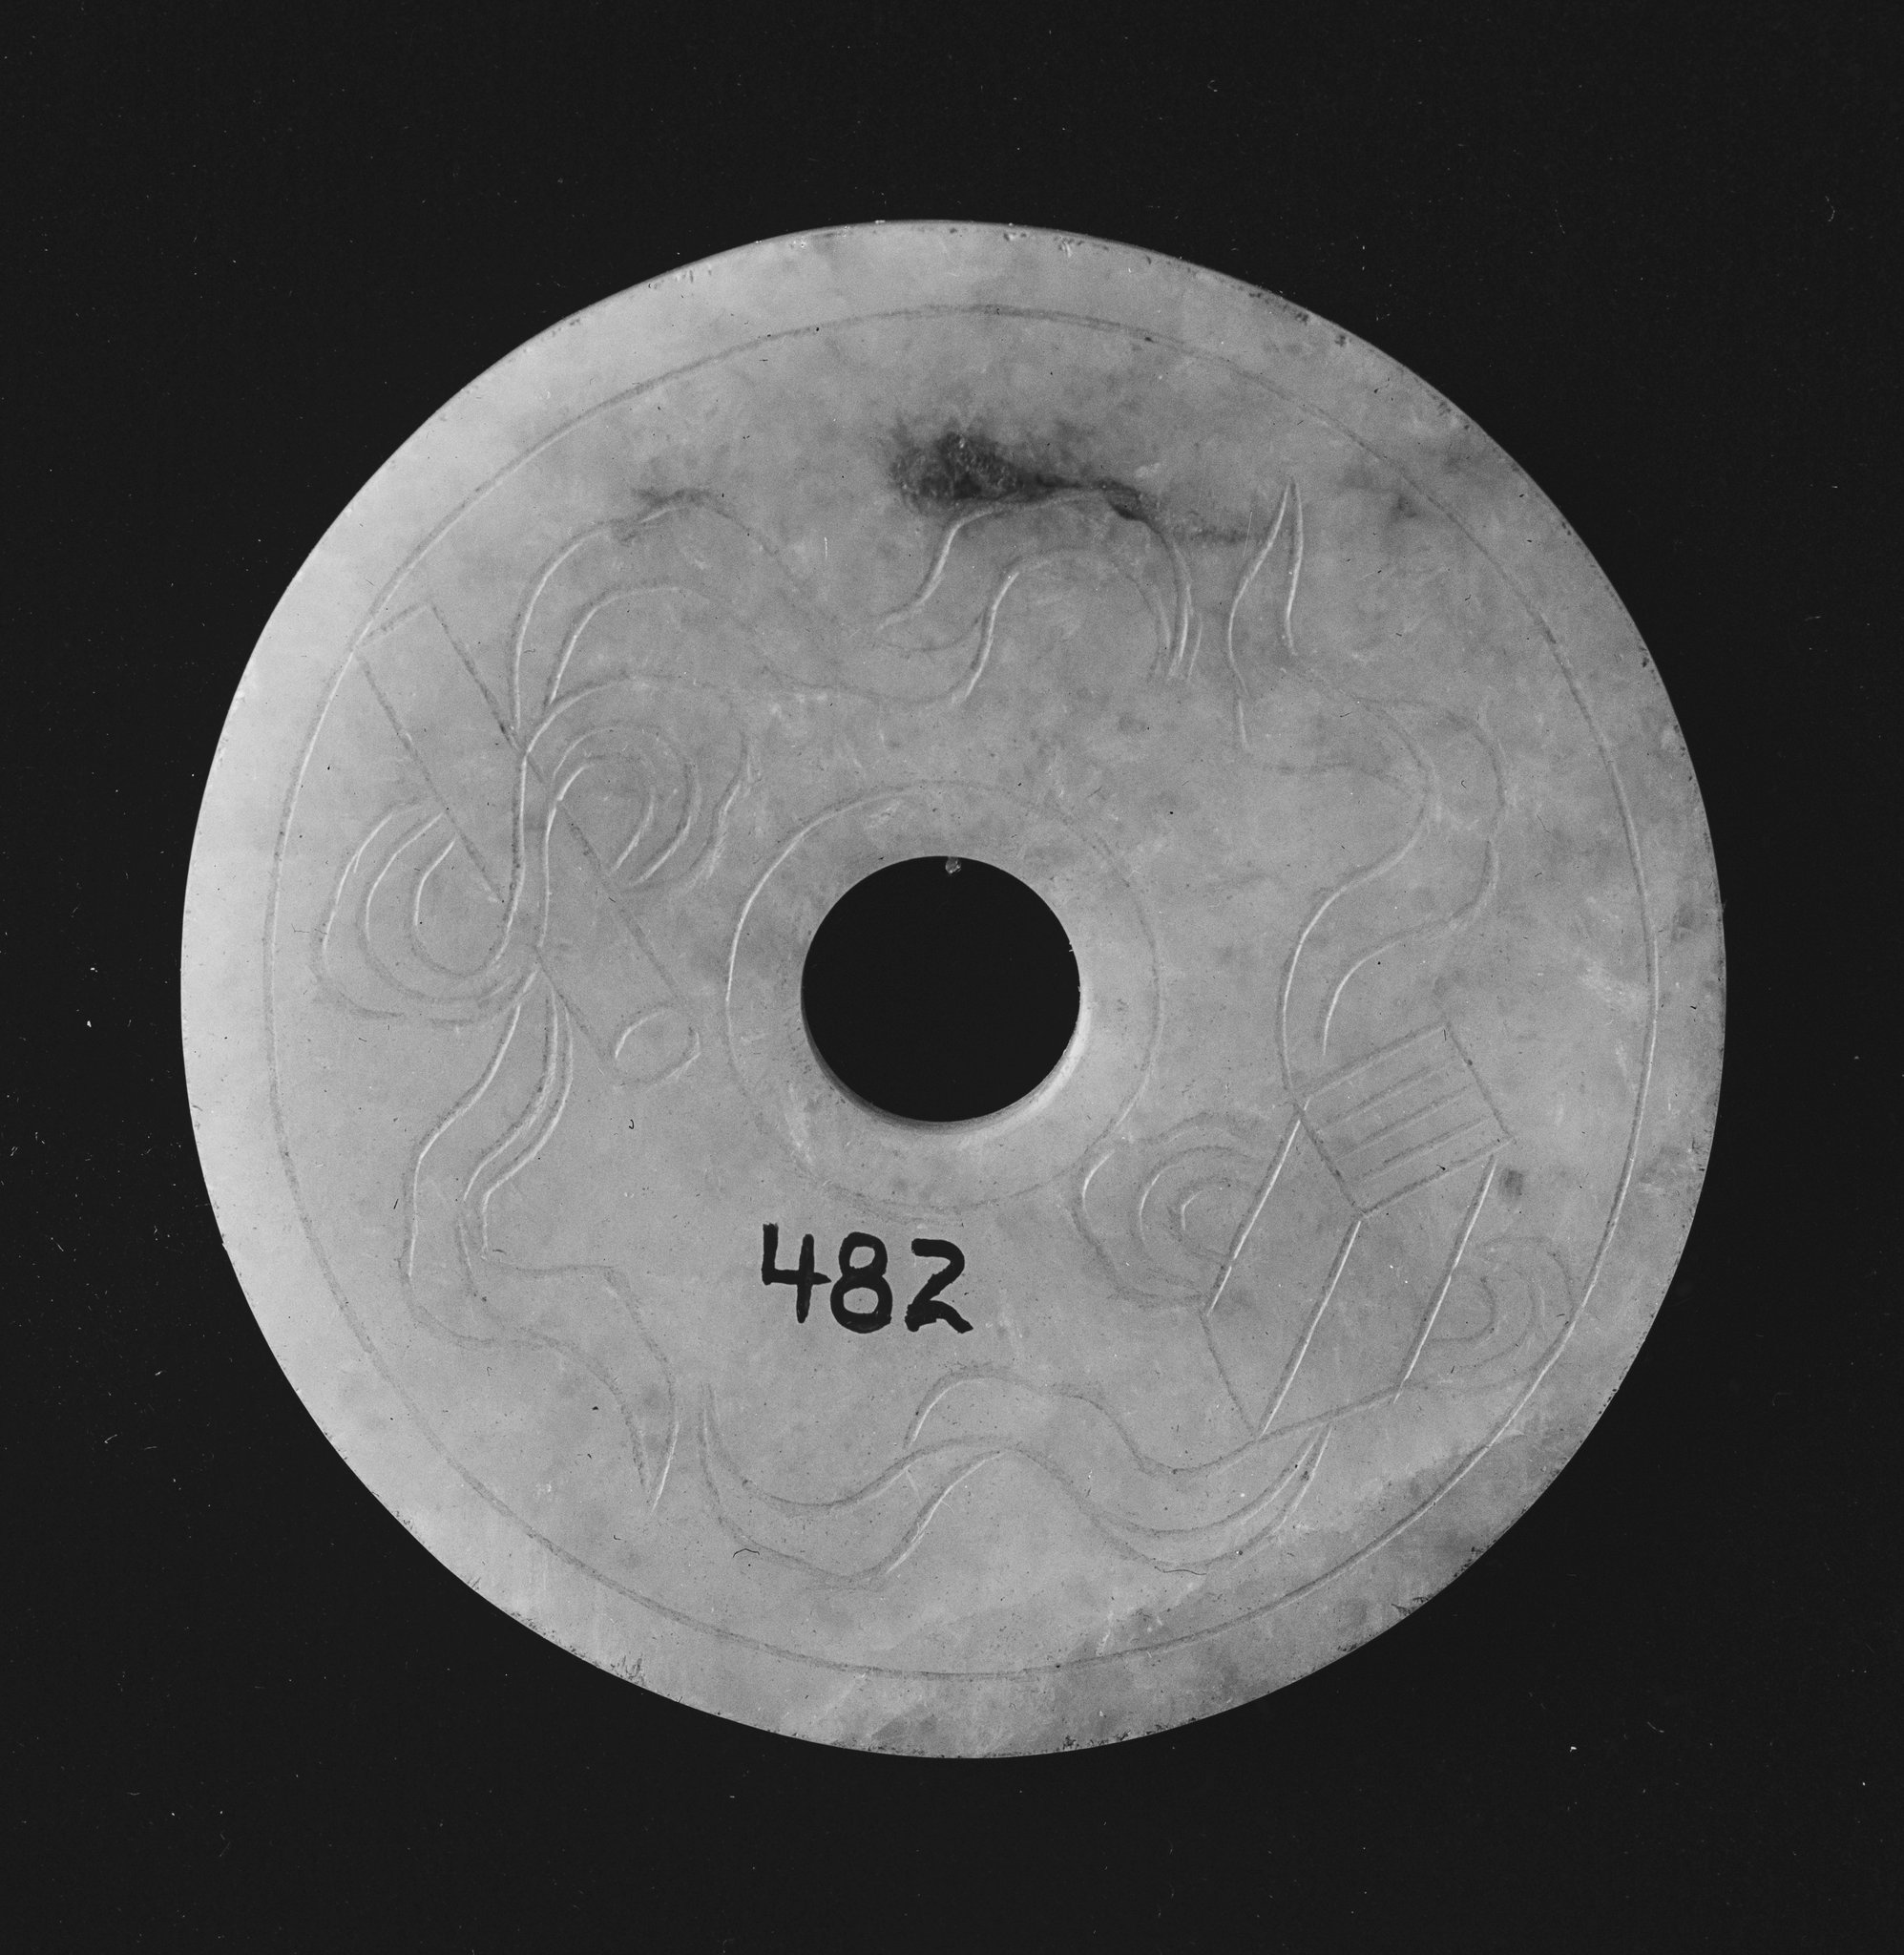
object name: medallion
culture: chinese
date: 1736-1795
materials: gemstone, jade